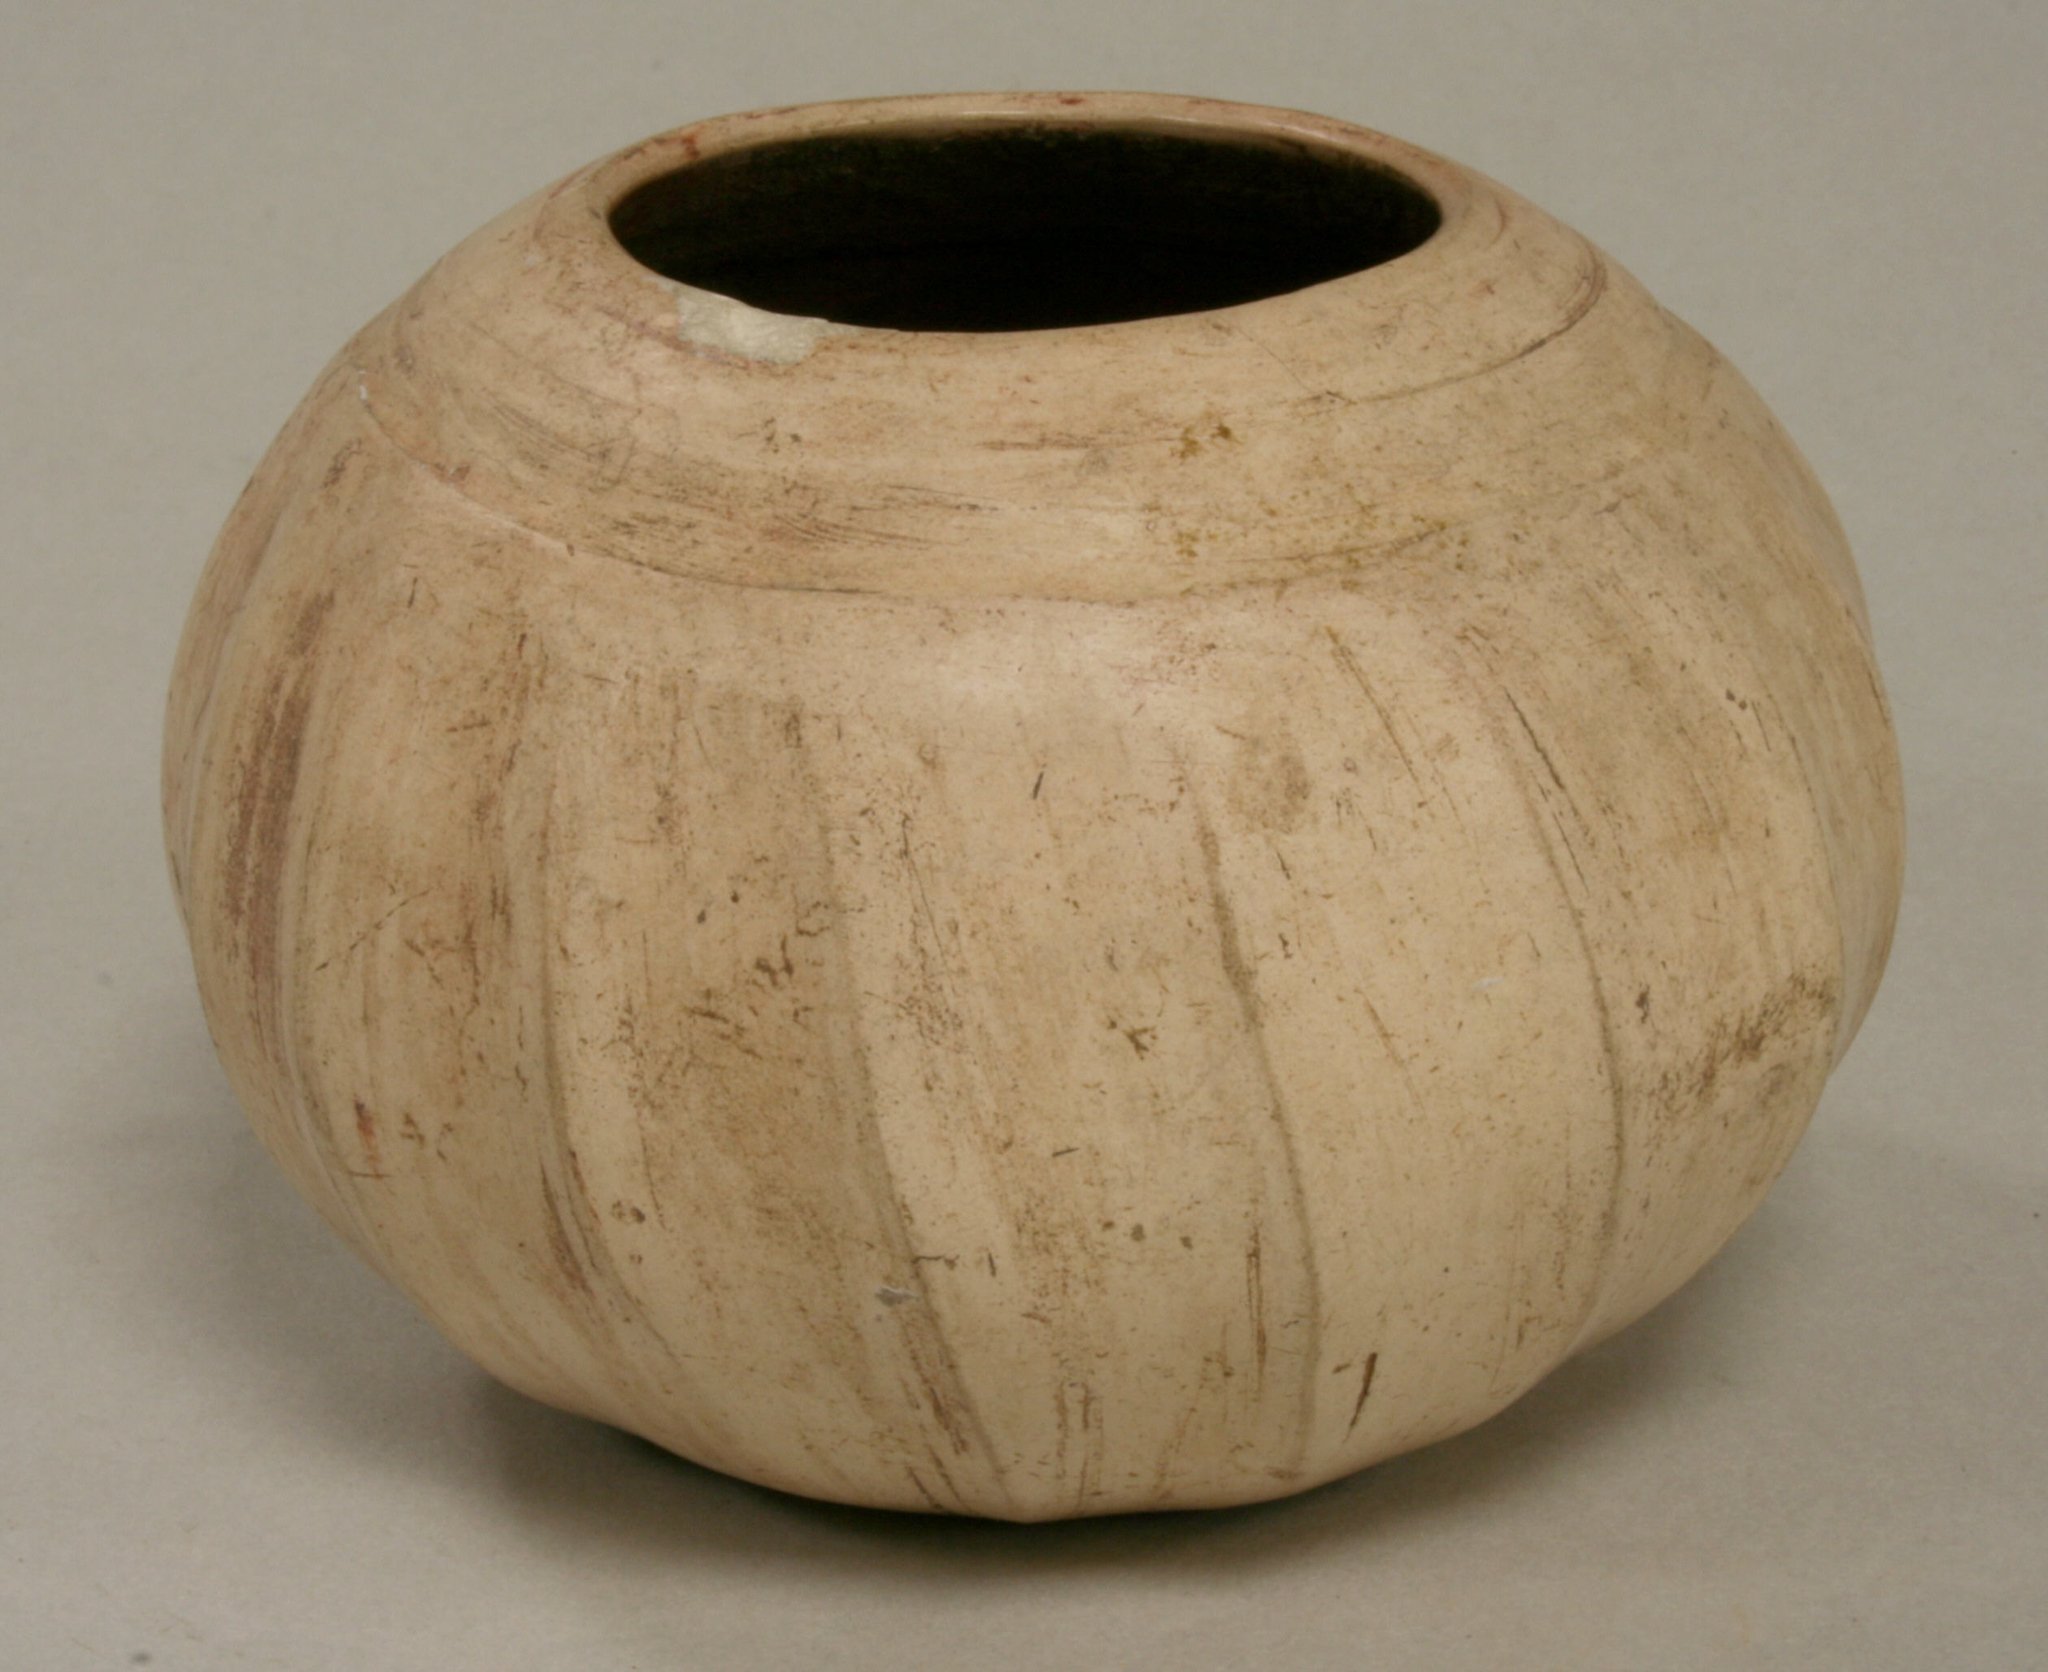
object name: bowl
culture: olmec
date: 1200-801 BCE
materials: ceramic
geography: mexico